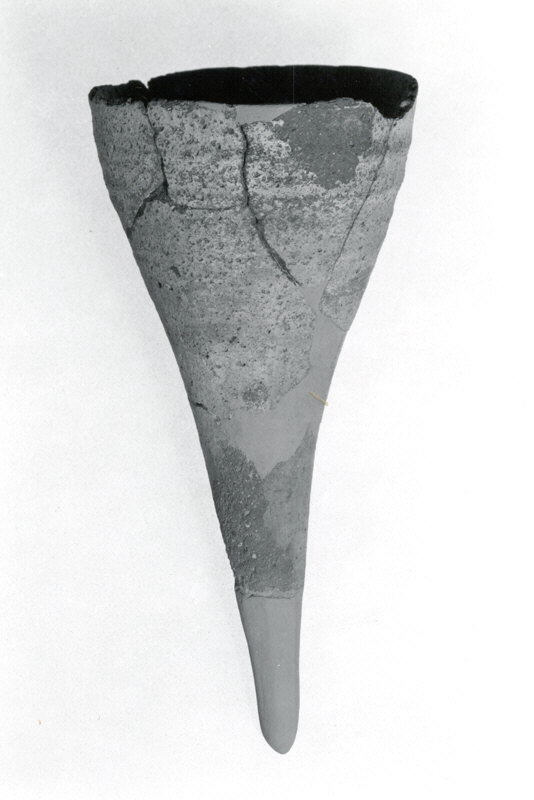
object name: cornet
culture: ghassulian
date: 4600-3600 BCE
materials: ceramic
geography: levant